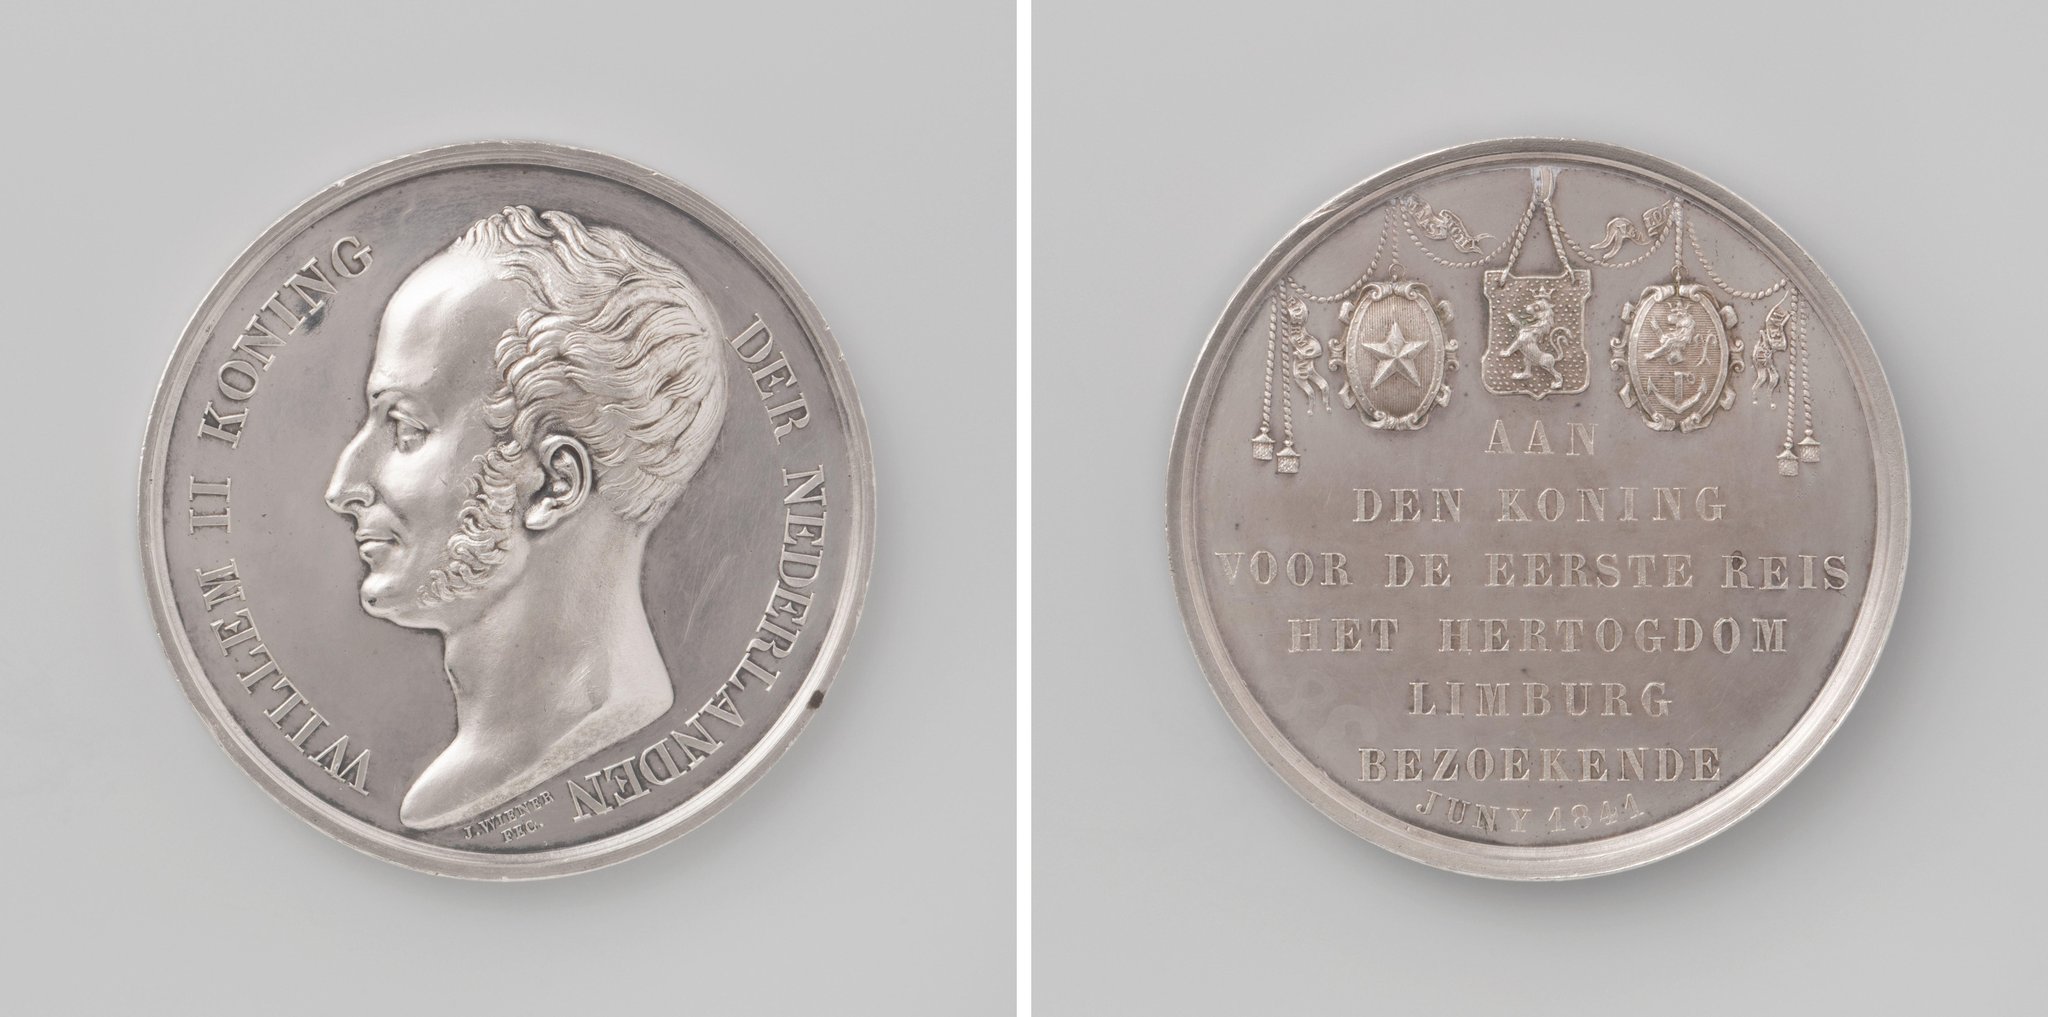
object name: history medal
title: Eerste bezoek van Willem II, koning der Nederlanden aan de provincie Limburg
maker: jacob wiener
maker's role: medailleur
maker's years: 1815-1899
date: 1841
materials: silver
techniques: striking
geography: brussels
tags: the hague, william ii of the netherlands, maastricht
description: Zilveren penning. Voorzijde: borststuk man binnen omschrift. Keerzijde: drie wapenschilden, hangende aan koord: guirlande met kwasten en wimpels boven opschrift.